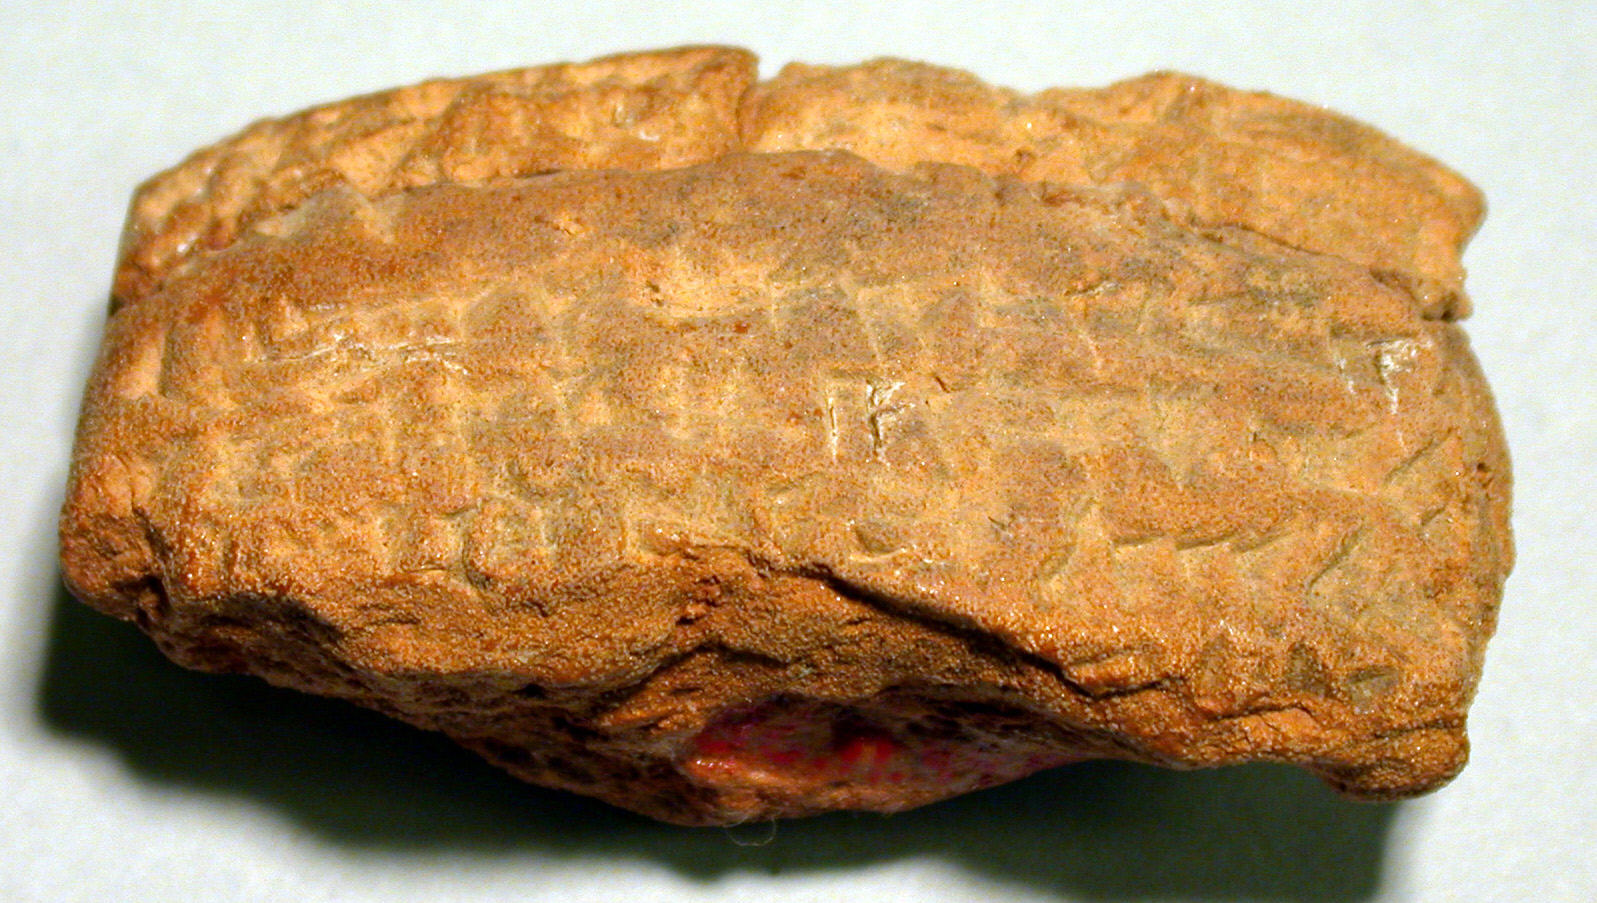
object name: cuneiform tablet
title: Cuneiform tablet: fragment of a witness list and date formula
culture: achaemenid or babylonian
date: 700-301 BCE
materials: clay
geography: mesopotamia